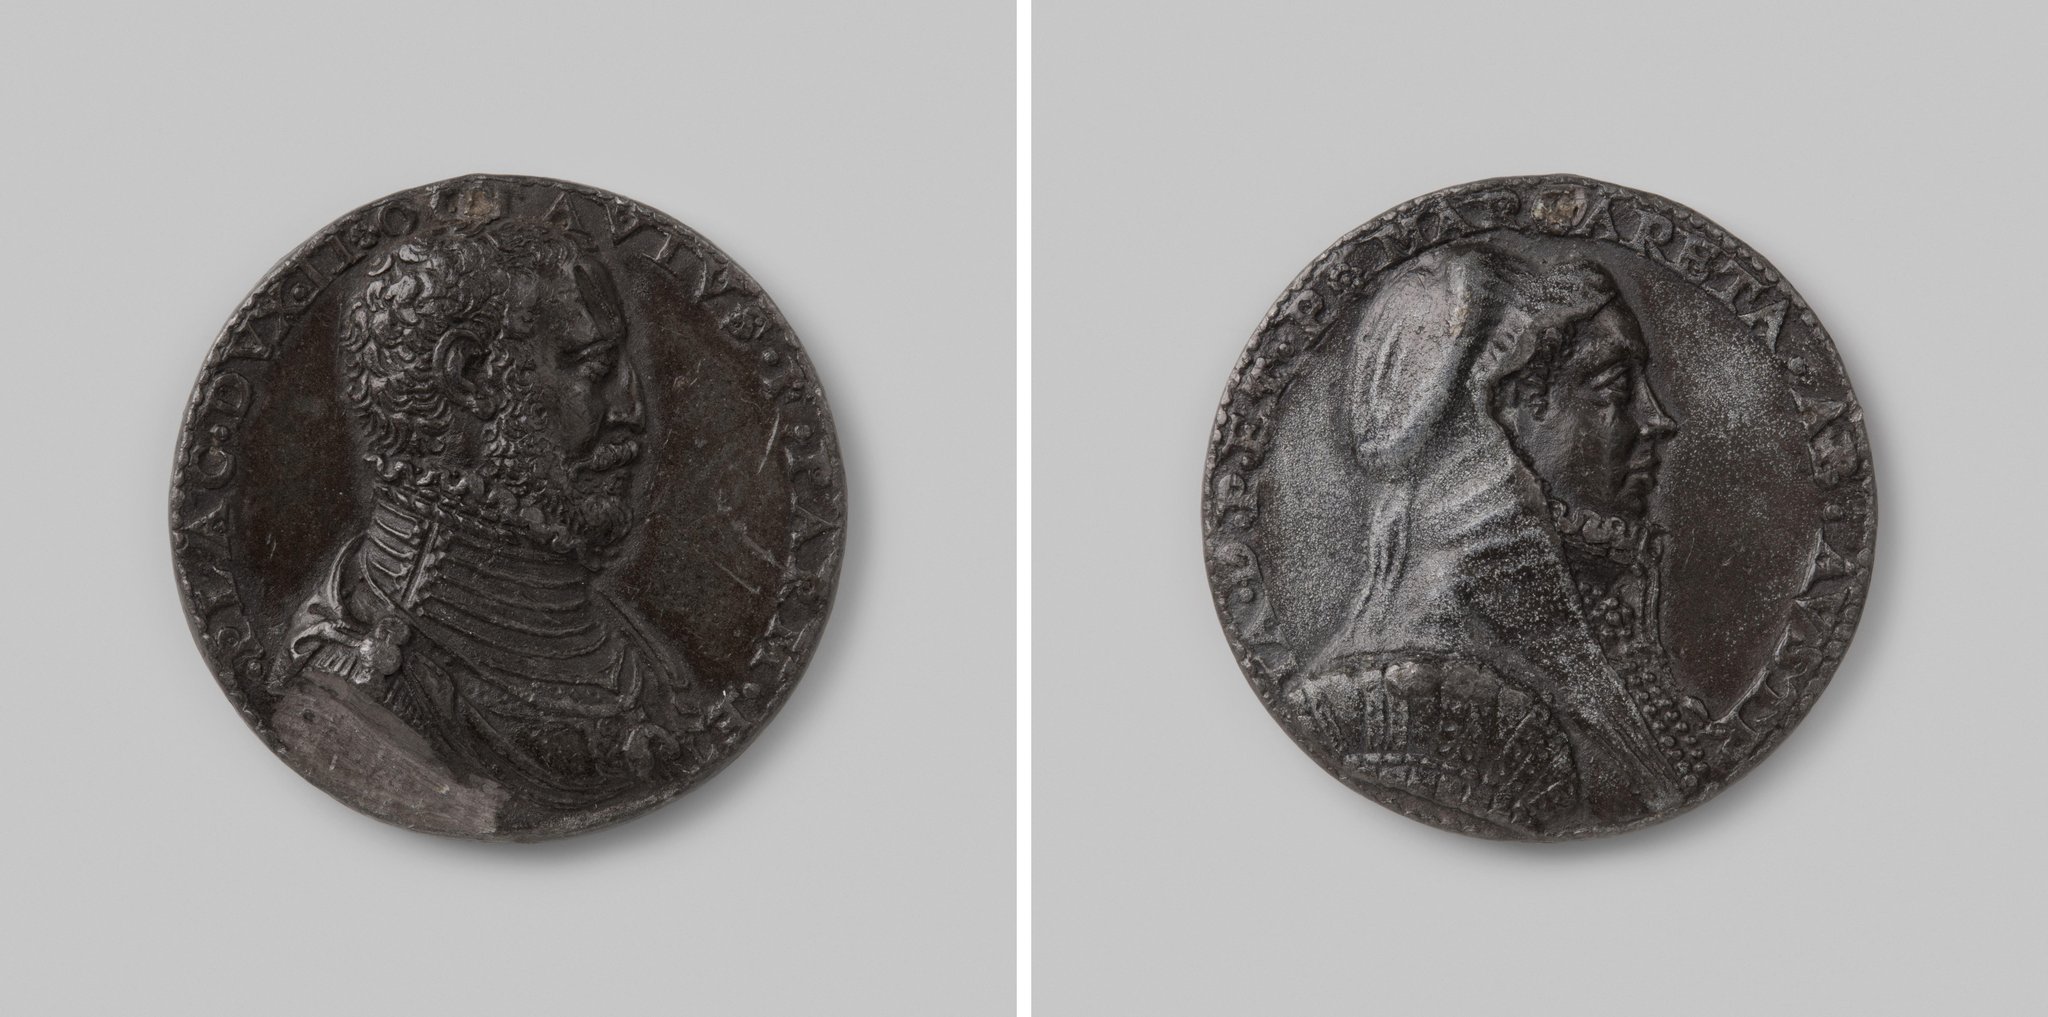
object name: copy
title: Margaretha van Parma en Ottavio Farnese van Parma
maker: Anonymous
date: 1559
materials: silver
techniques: casting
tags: oudenaarde, landvoogd, landvoogdes der nederlanden margaretha van parma, hertog, ottavio farnese (hertog van parma en piacenza)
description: Zilveren penning. Voorzijde: borststuk man binnen omschrift. Keerzijde: borststuk vrouw binnen omschrift